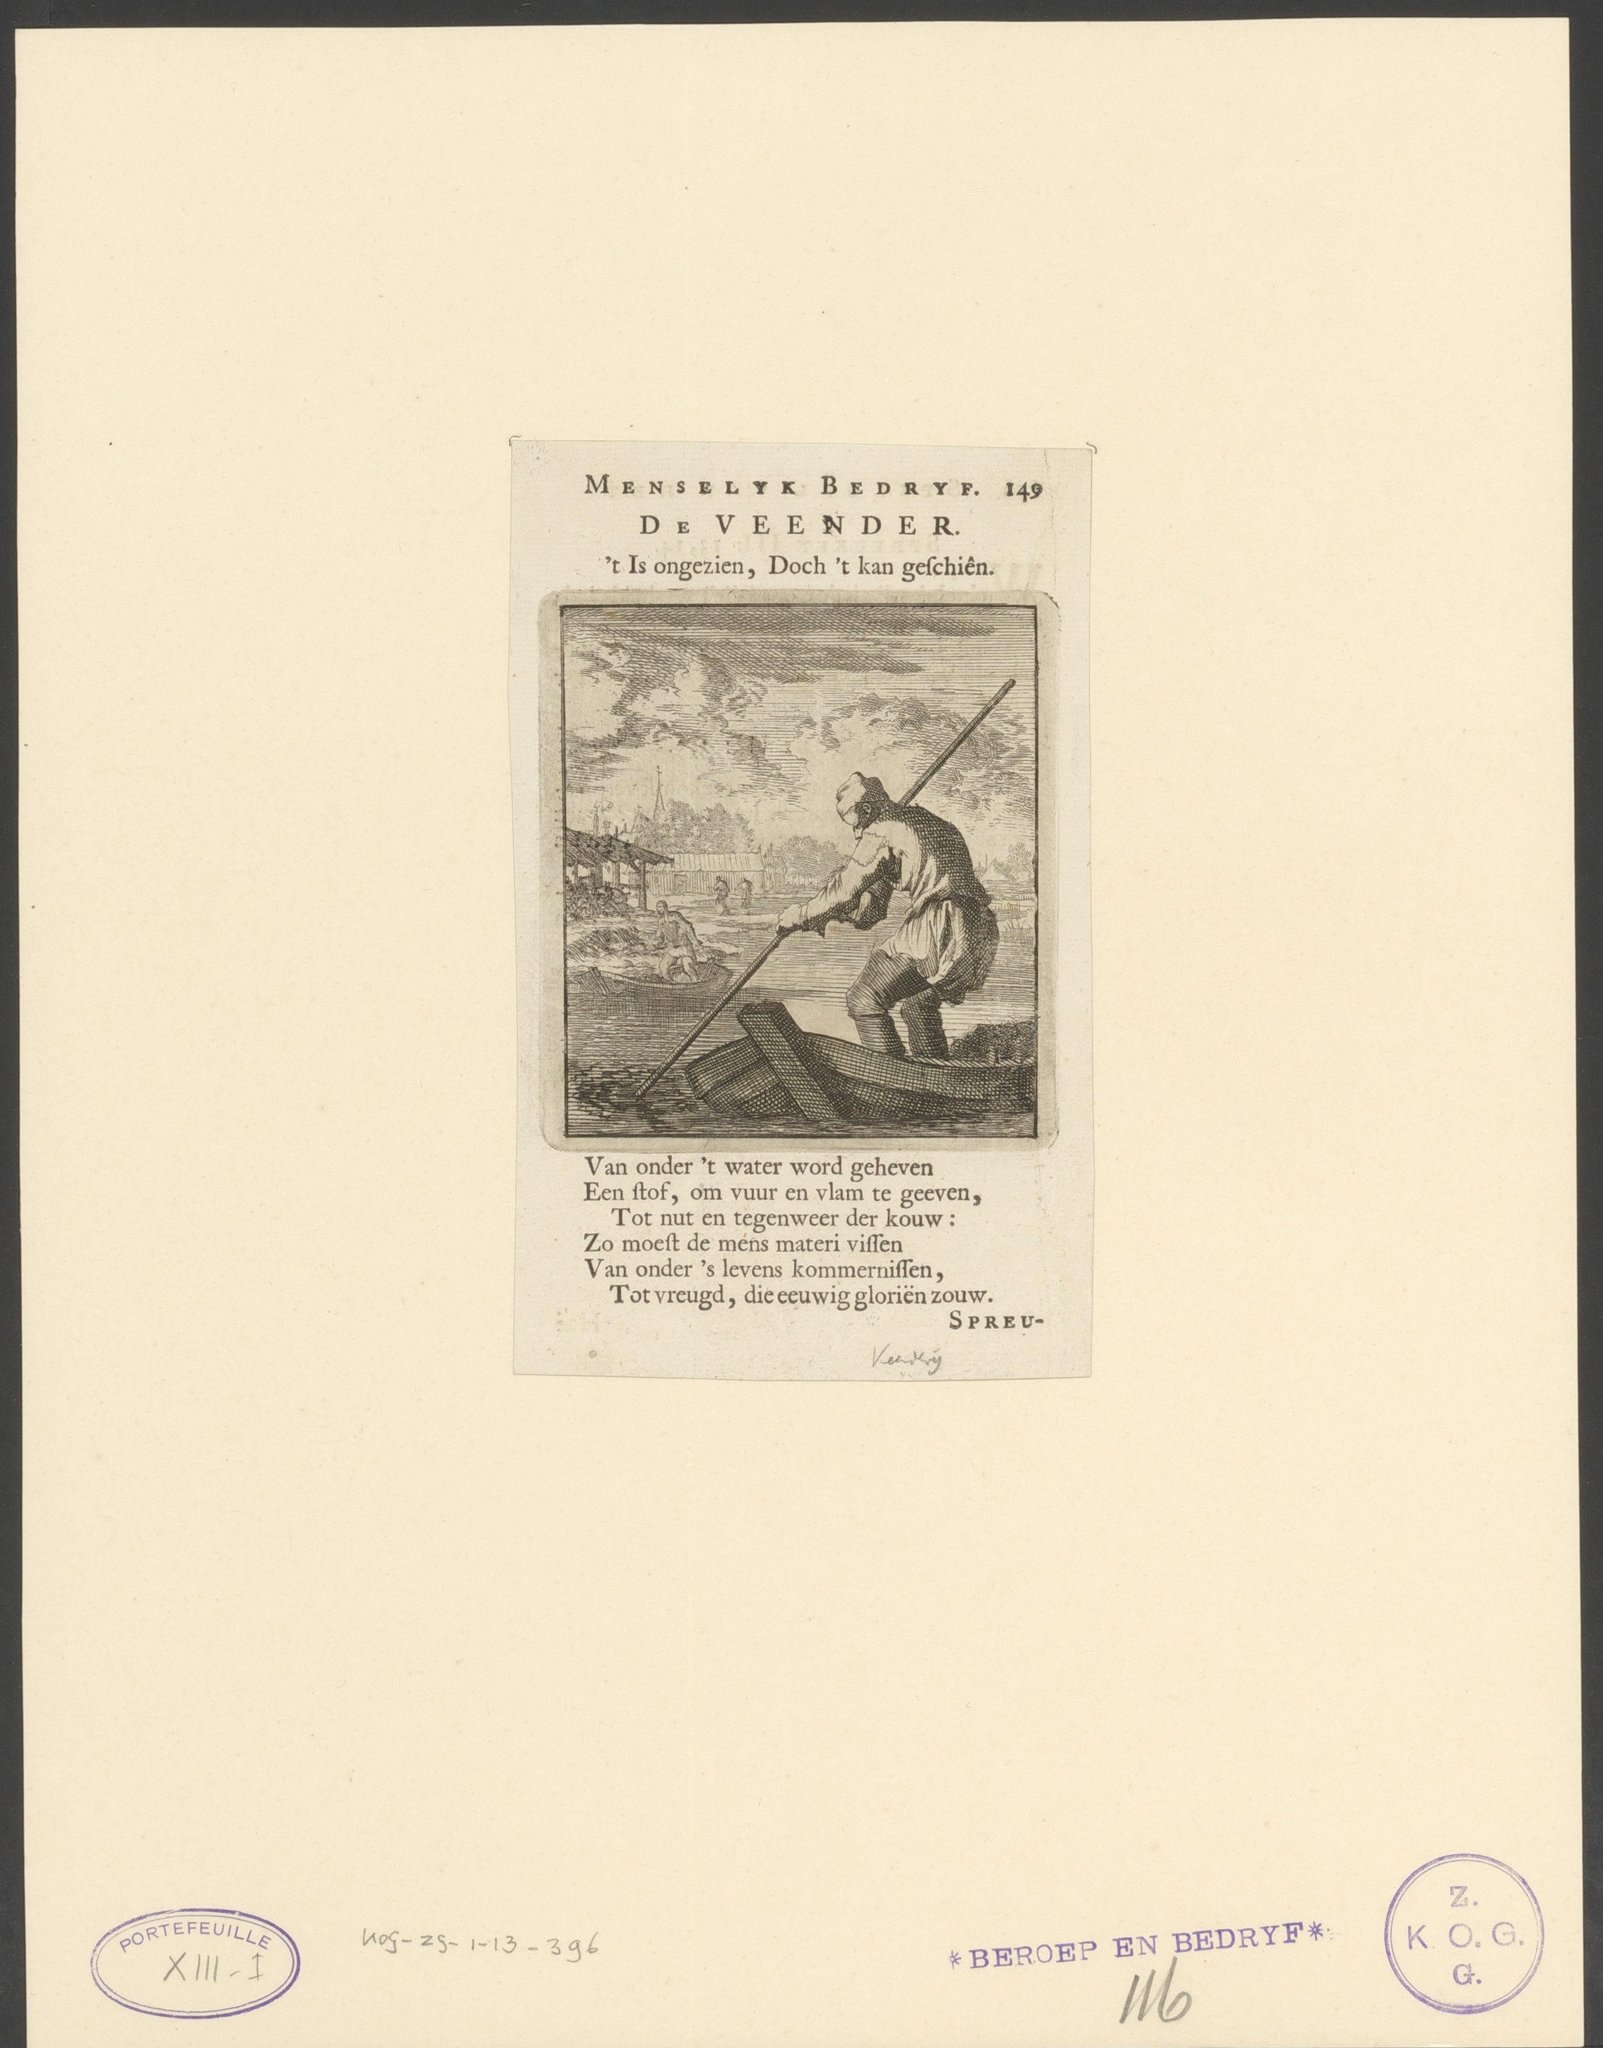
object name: print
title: Veengraver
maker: cornelis van der sys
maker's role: publisher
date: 1718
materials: paper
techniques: etching, letterpress printing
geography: amsterdam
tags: handicrafts, craftsman at work, peat-cutting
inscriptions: collector's mark: Lugt 1641, stamp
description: Prent oorspronkelijk verschenen in de 100-delige serie beroepsprenten van Jan en Caspar Luyken, getiteld: Het menselyk bedryf. S.l.s.n., 1694 (eerste druk). Daarna is de titel en het vers afgesneden. De prenten in diverse publicaties verschenen en gekopieerd. Huidige staat uit: Luyken, Jan en Caspar. Spiegel van het menselyk bedryf (...). Amsterdam: Cornelis van der Sys, 1718, p. 149. Prent waarschijnlijk ook gebruikt in eerdere (1704) en latere (1730, 1749, 1767) publicaties.